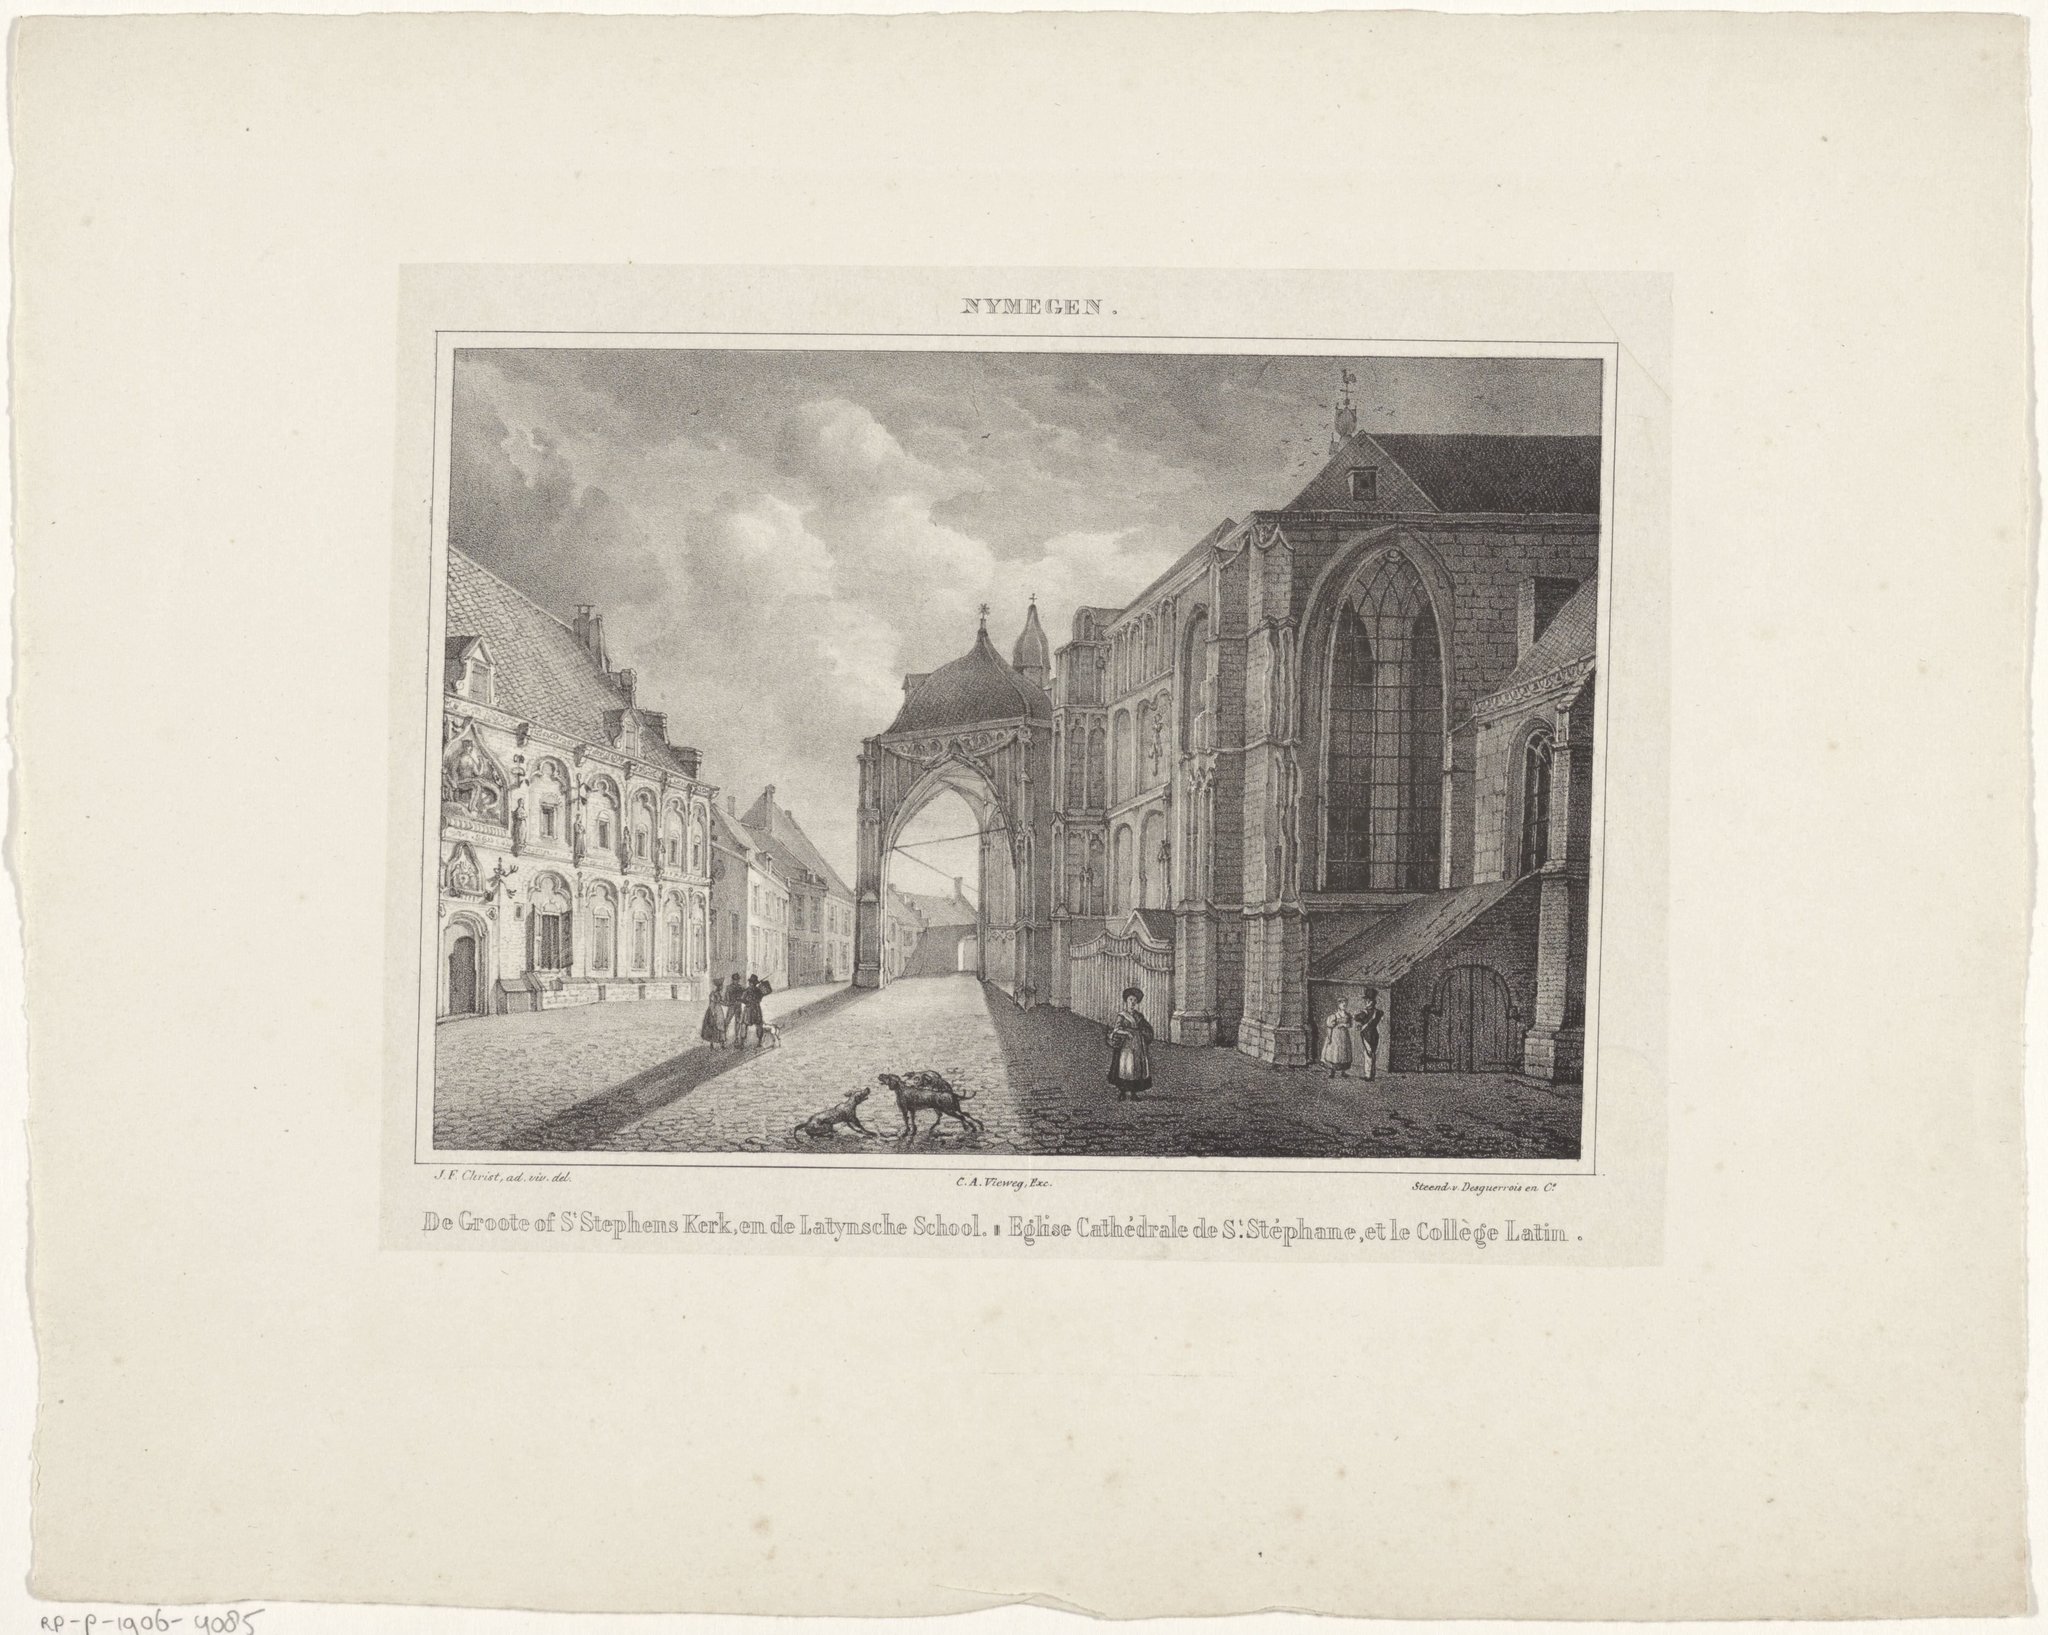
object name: print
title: Nymegen.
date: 1834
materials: paper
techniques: lithograph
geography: amsterdam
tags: parts of church exterior and annexes: portal, city-view in general; 'veduta', nijmegen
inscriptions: collector's mark: Lugt 2228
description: Links aan de straat staat de Latijnse School met een facade in vroegrenaissance stijl. Op het plein lopen figuren en honden. In het midden is het Zuiderportaal van de Stevenskerk te zien. Deze prent maakt deel uit van een serie over Nijmegen.